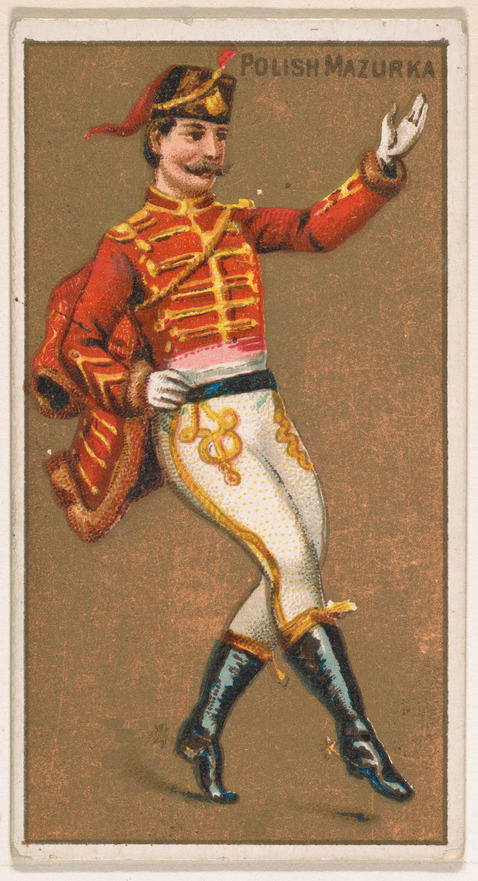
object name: print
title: Polish Mazurka, from National Dances (N225, Type 1) issued by Kinney Bros.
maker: kinney brothers tobacco company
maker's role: publisher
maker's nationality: american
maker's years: 1869-2011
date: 1889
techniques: color lithograph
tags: men,dancing,dancers